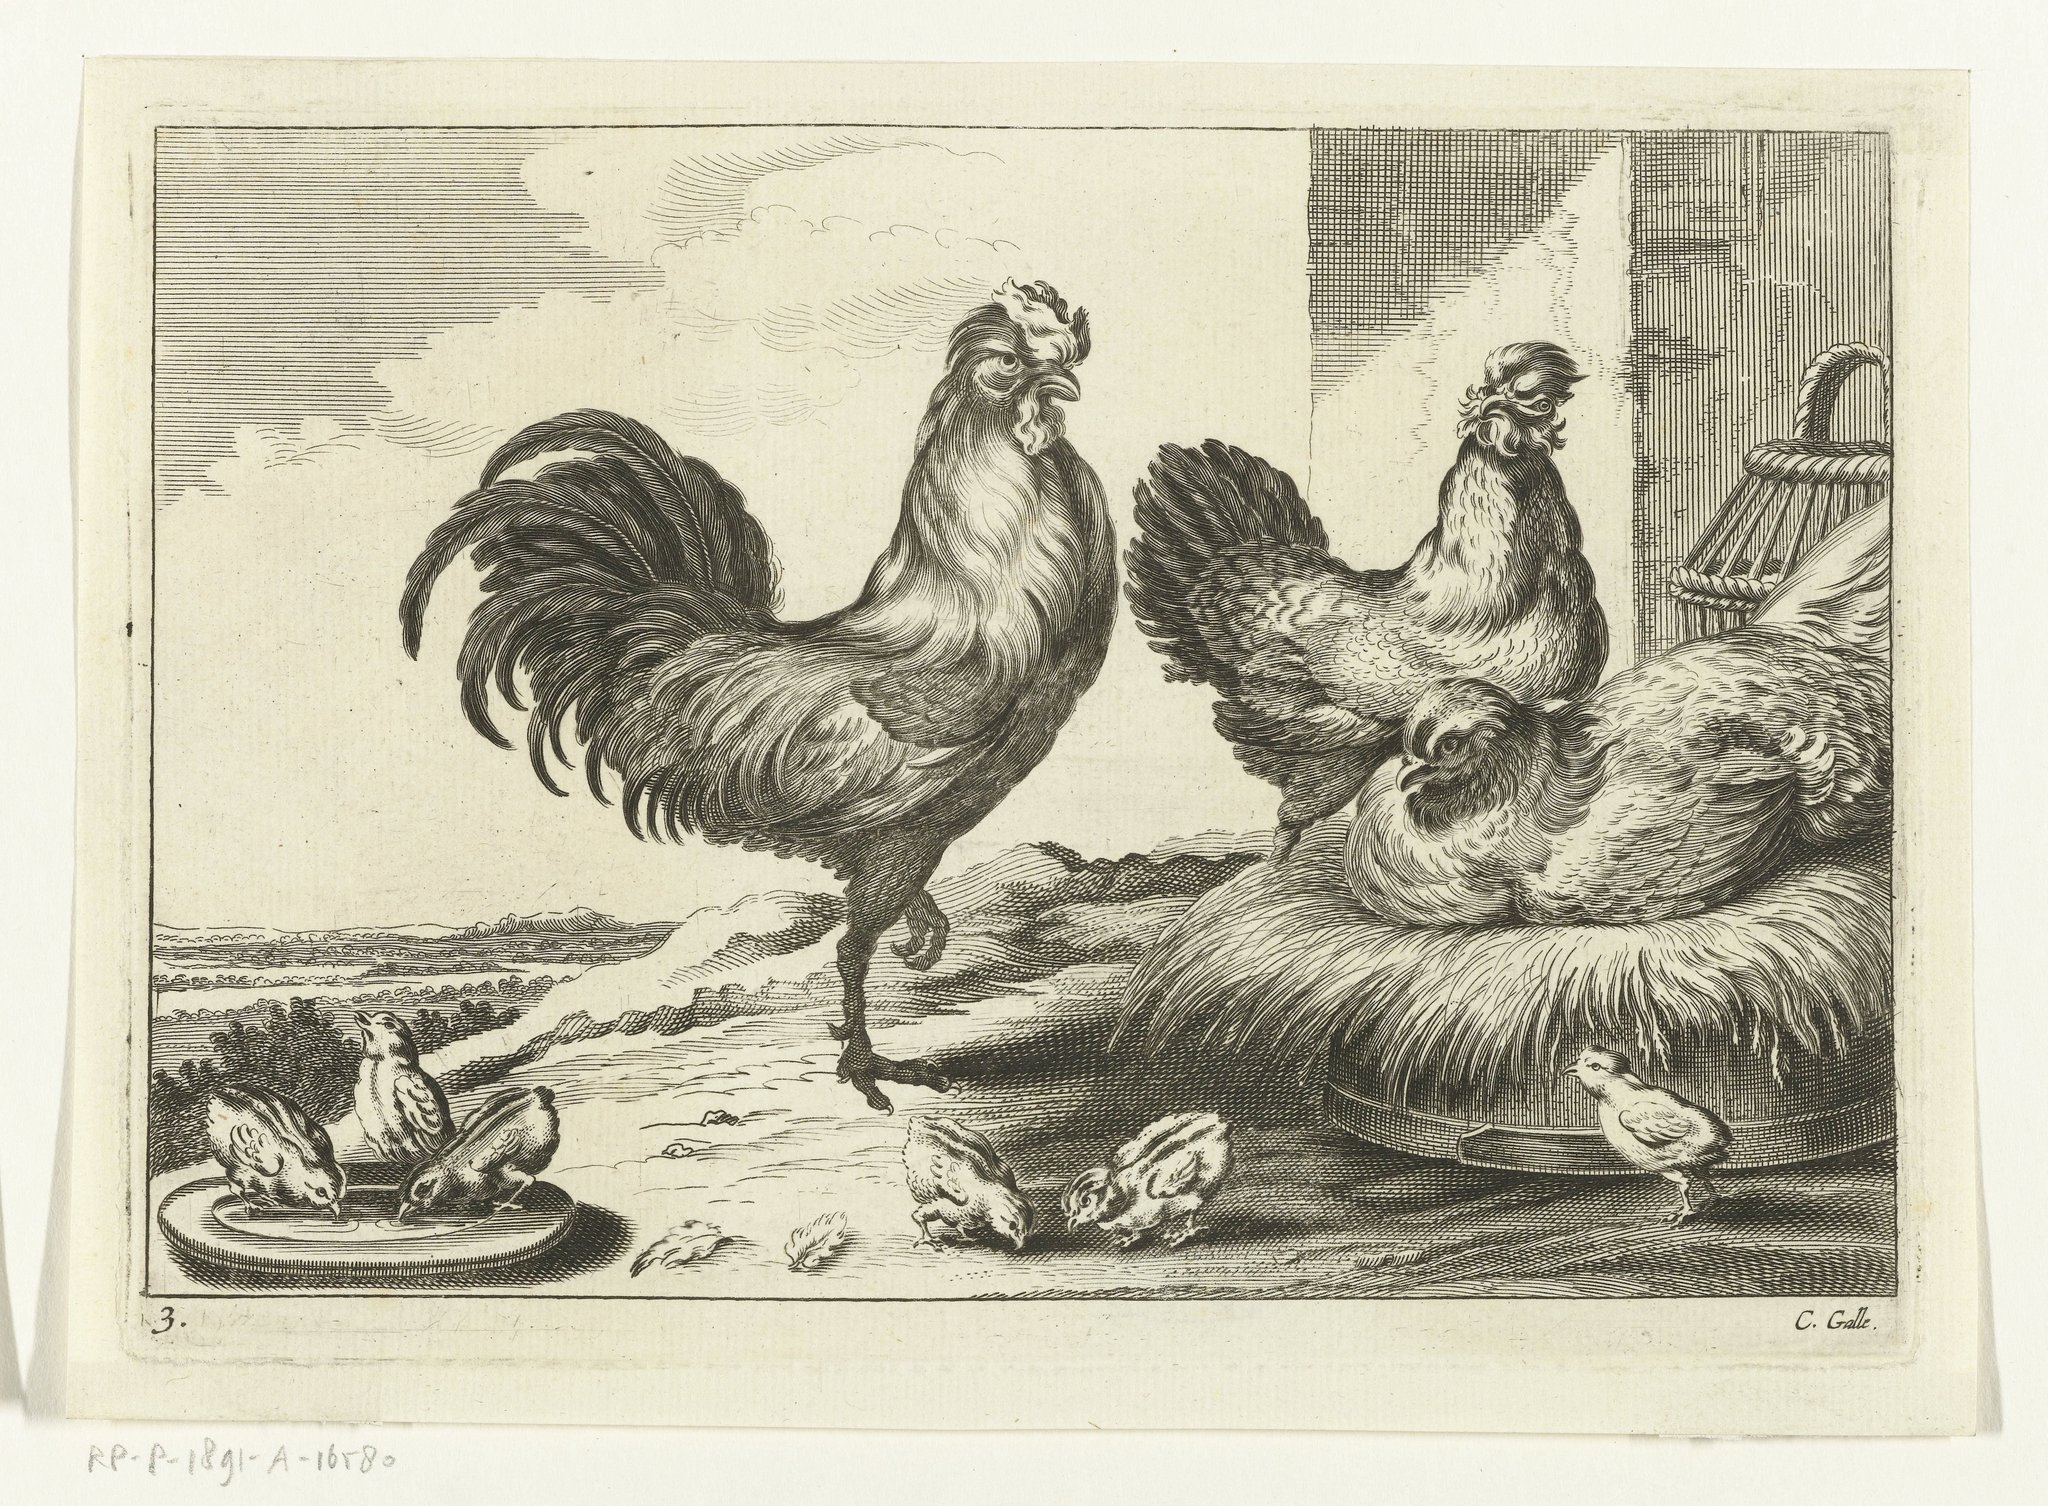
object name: print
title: Verschillende vogels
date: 1654-1678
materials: paper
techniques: engraving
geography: antwerp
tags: fowl (cock, hen, chicken, etc.)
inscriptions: collector's mark: Lugt 2228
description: Prent maakt deel uit van de zeventiendelige serie met voorstellingen van verschillende vogels: "Diversarum avium species".